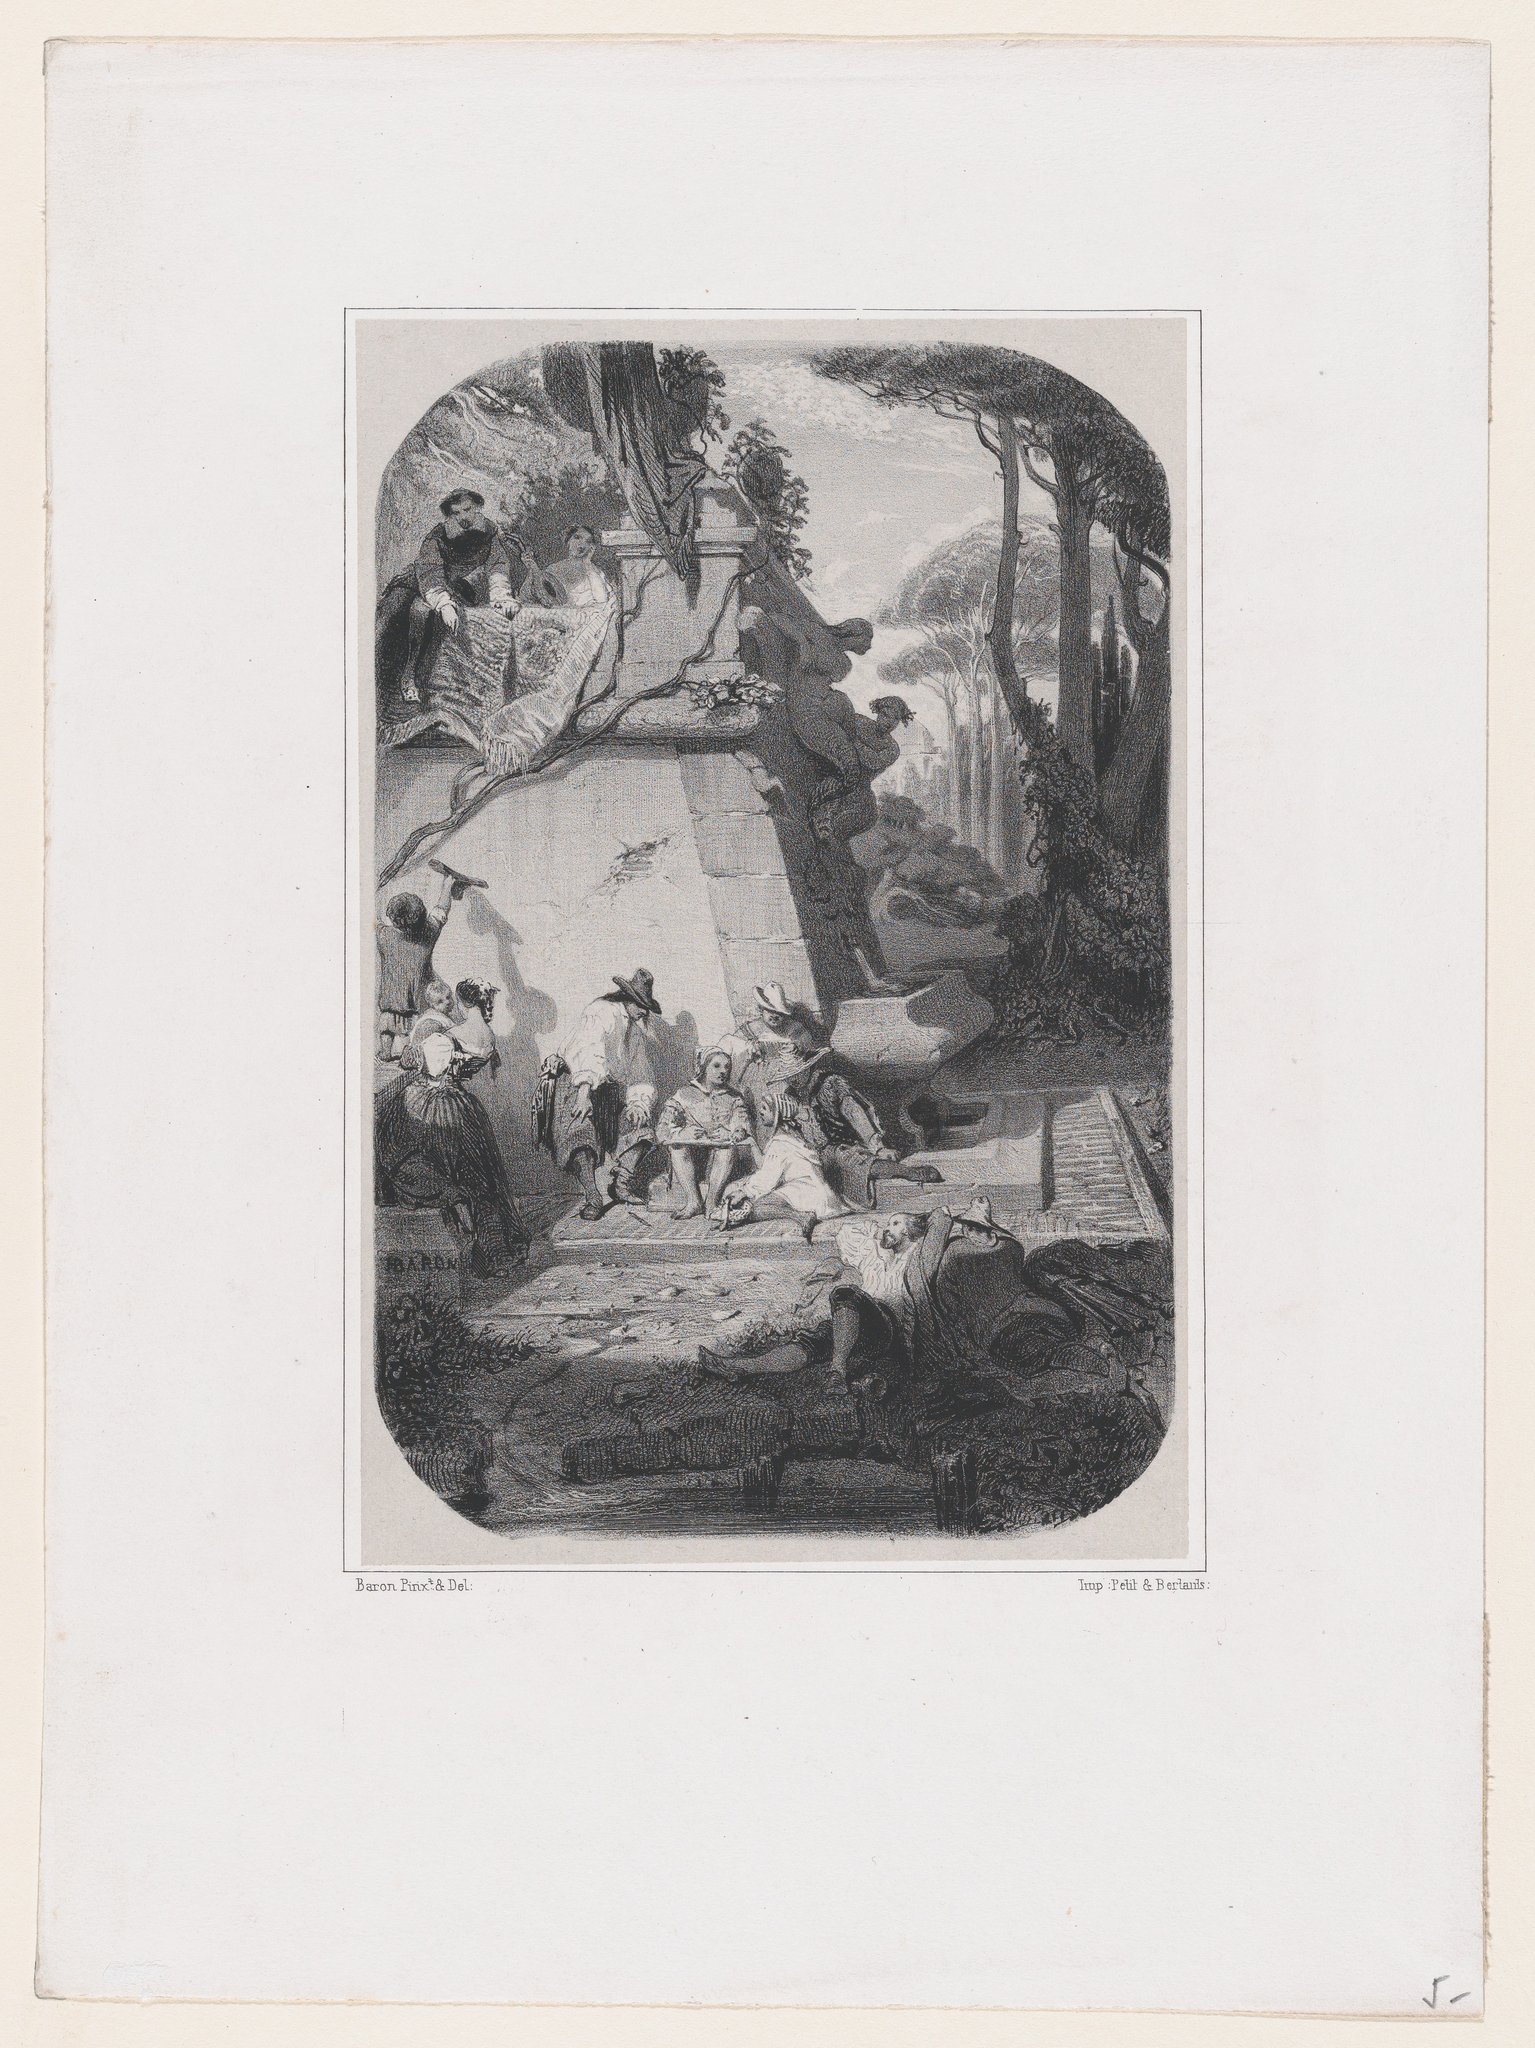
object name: print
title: A Siesta in Italy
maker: henri-charles-antoine baron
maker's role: artist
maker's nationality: french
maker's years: 1816-1885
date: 1842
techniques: lithograph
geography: germany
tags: children,men,women